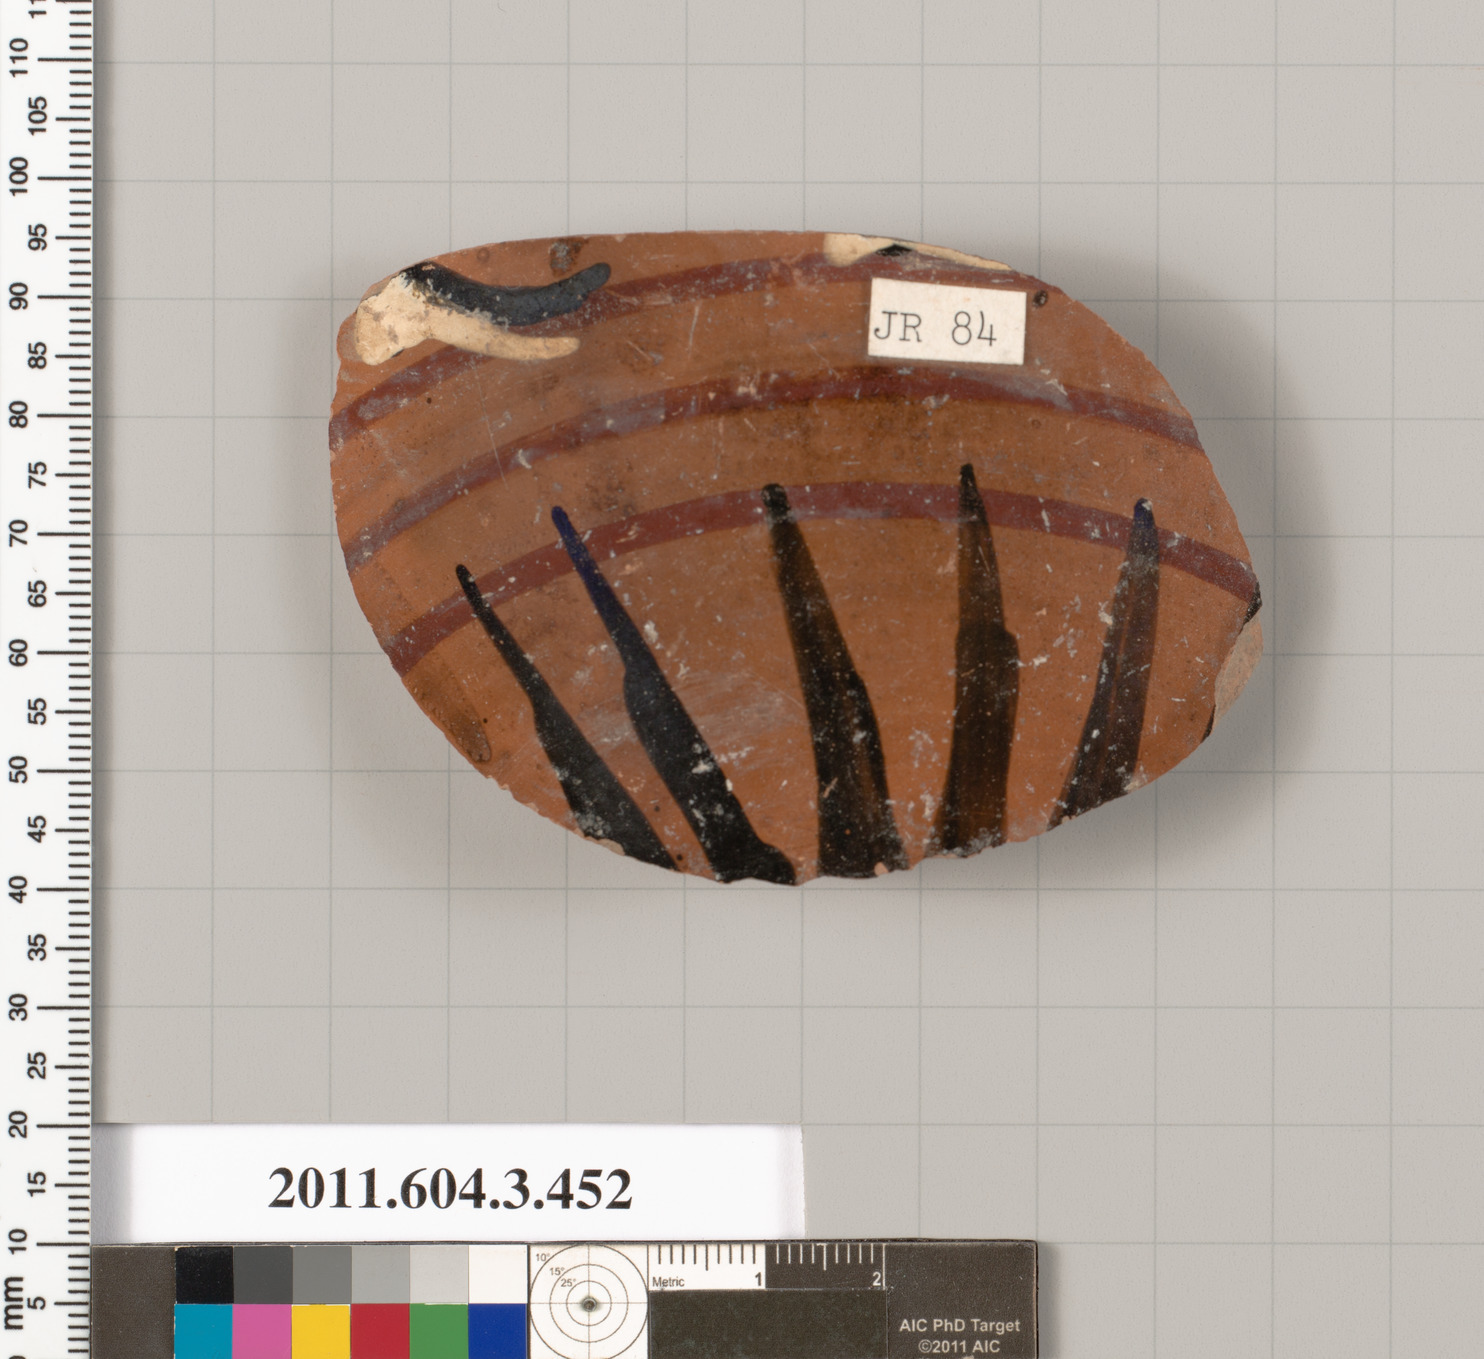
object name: neck amphora fragment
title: Terracotta fragment of a neck-amphora (jar)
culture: greek, attic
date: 490-480 BCE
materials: terracotta